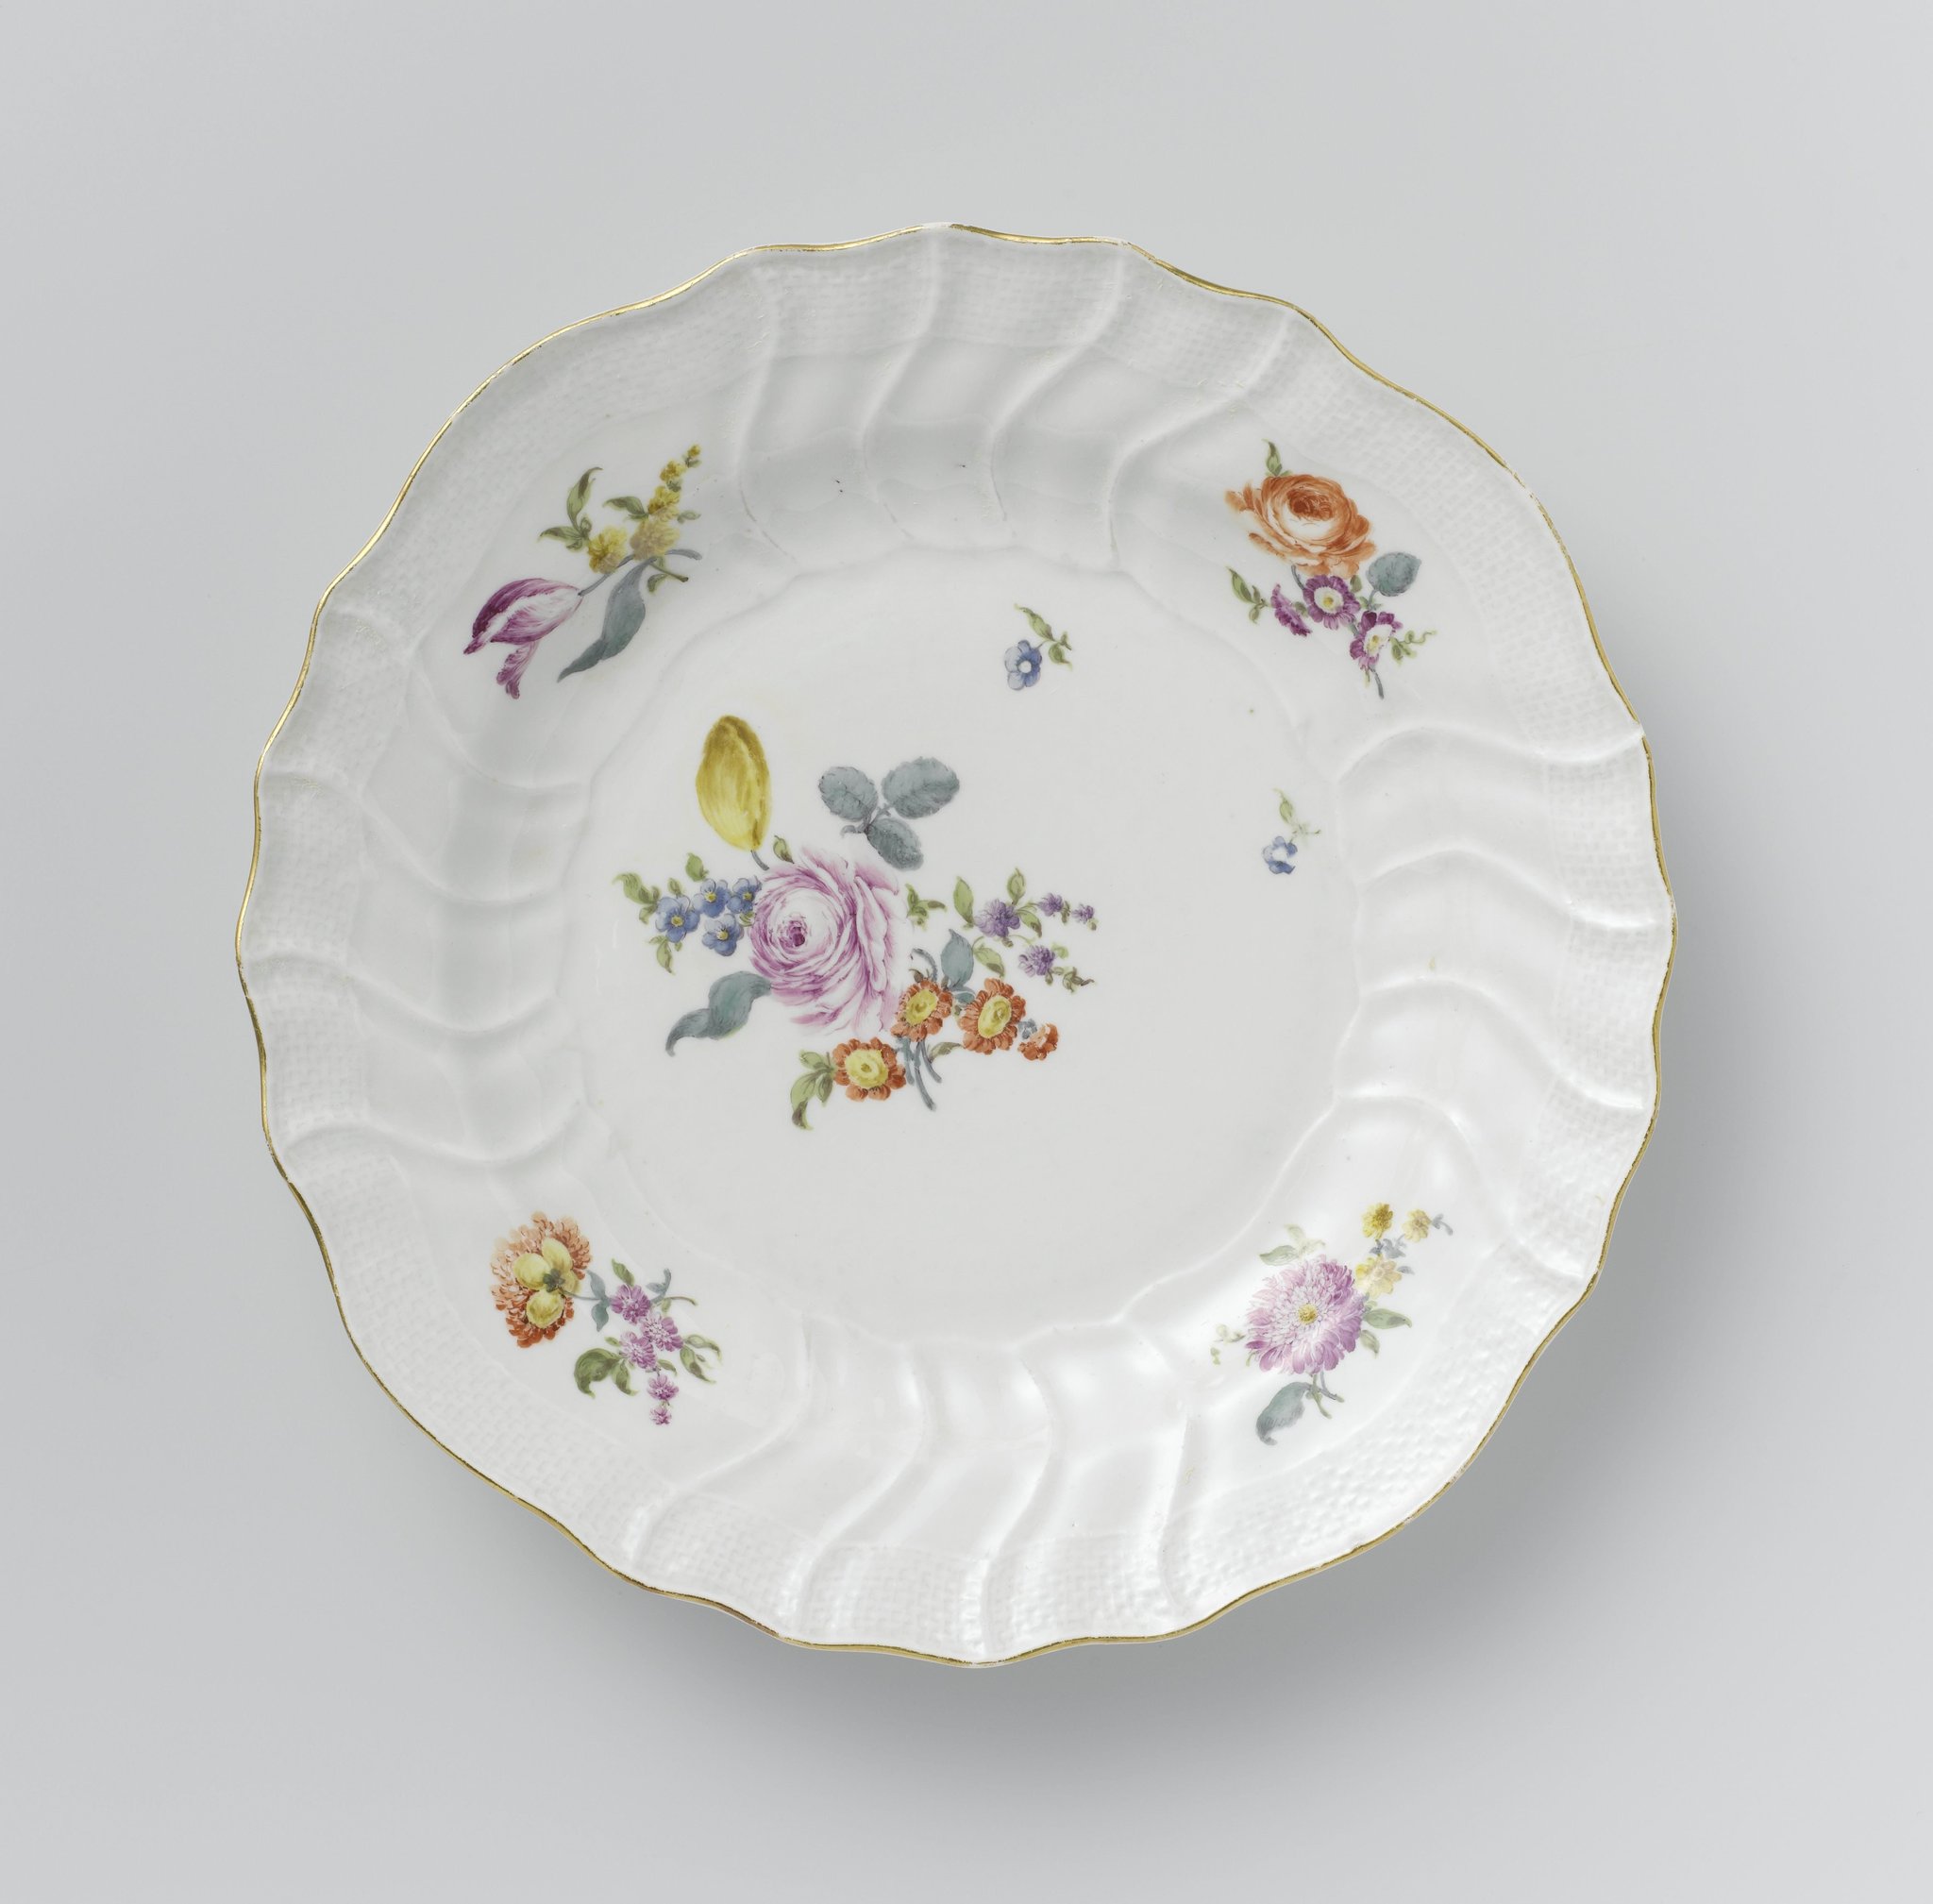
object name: eating drinking utensil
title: Bord, veelkleurig beschilderd met Deutsche Blumen, insekten en vruchten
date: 1750-1760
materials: porcelain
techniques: painted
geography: meissen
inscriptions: factory mark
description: Rond bord van beschilderd porselein. Het bord is beschilderd met Deutsche Blumen, insekten en vruchten. De rand is in reliëf versierd met het Neuozier-patroon. Het bord is gemerkt en hoort bij een servies (BK-17474-1 t/m BK-17474-253).